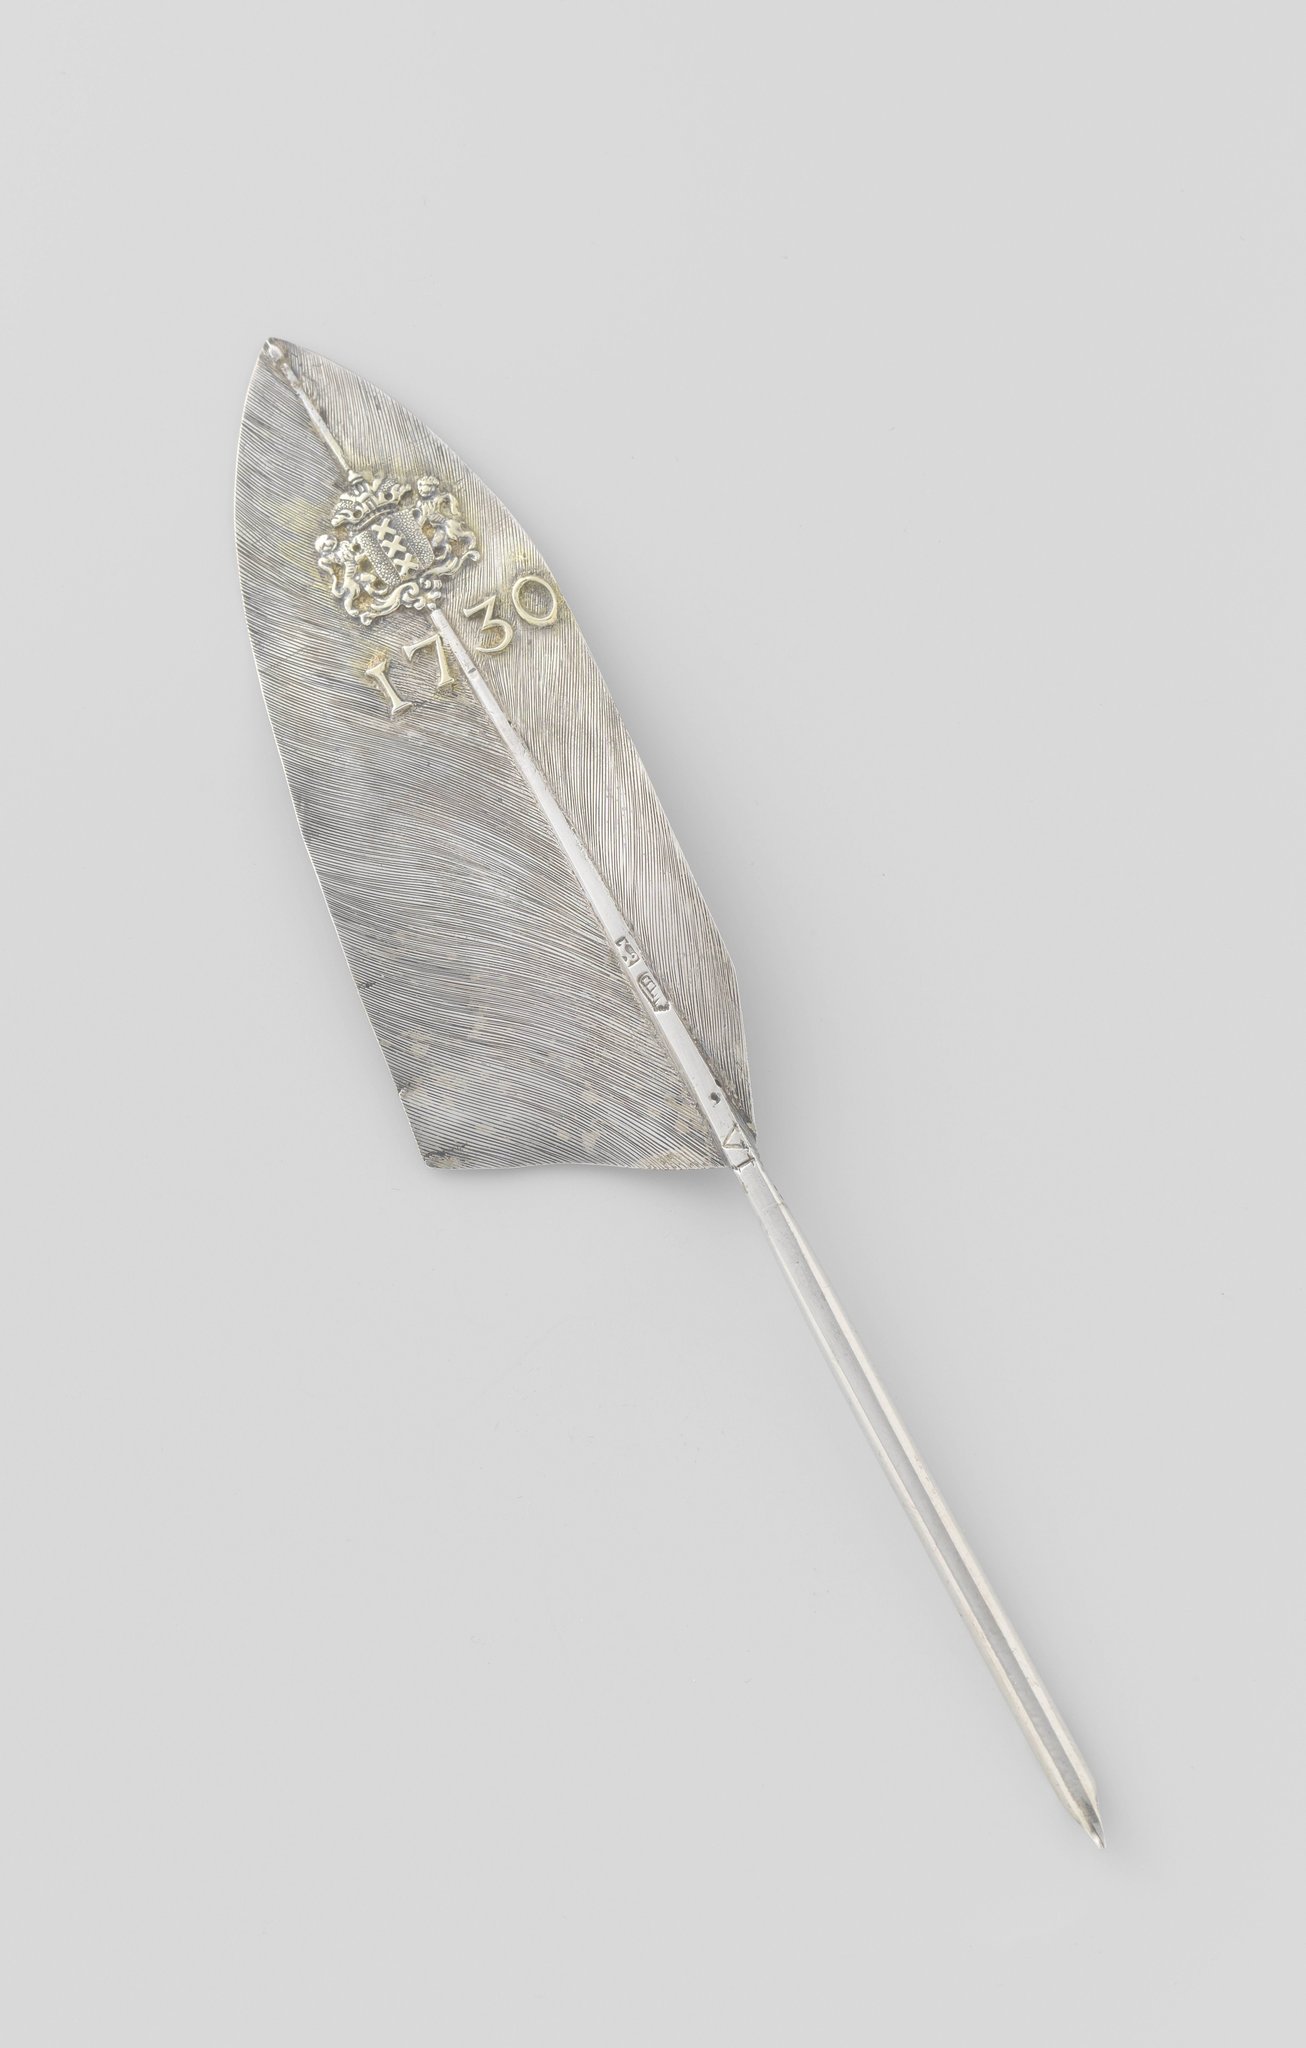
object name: prijspen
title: Prijspen in de vorm van een ganzenveer met het jaartal 1730 en het wapen van Amsterdam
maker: hendrik de hondt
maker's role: silversmith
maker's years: 1656-1741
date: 1730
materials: silver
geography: amsterdam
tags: quill, amsterdam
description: Prijspen van zilver in de vorm van een ganzenveer, waarop het gegoten, gekroonde wapen van Amsterdam , gehouden door leeuwen die staan op twee bladvoluten ter weerszijden van een culot, is geappliqeerd. Daaronder is het gegoten jaartal 1730 geappliqueerd. In de schacht is het cijfer VI gegrift.